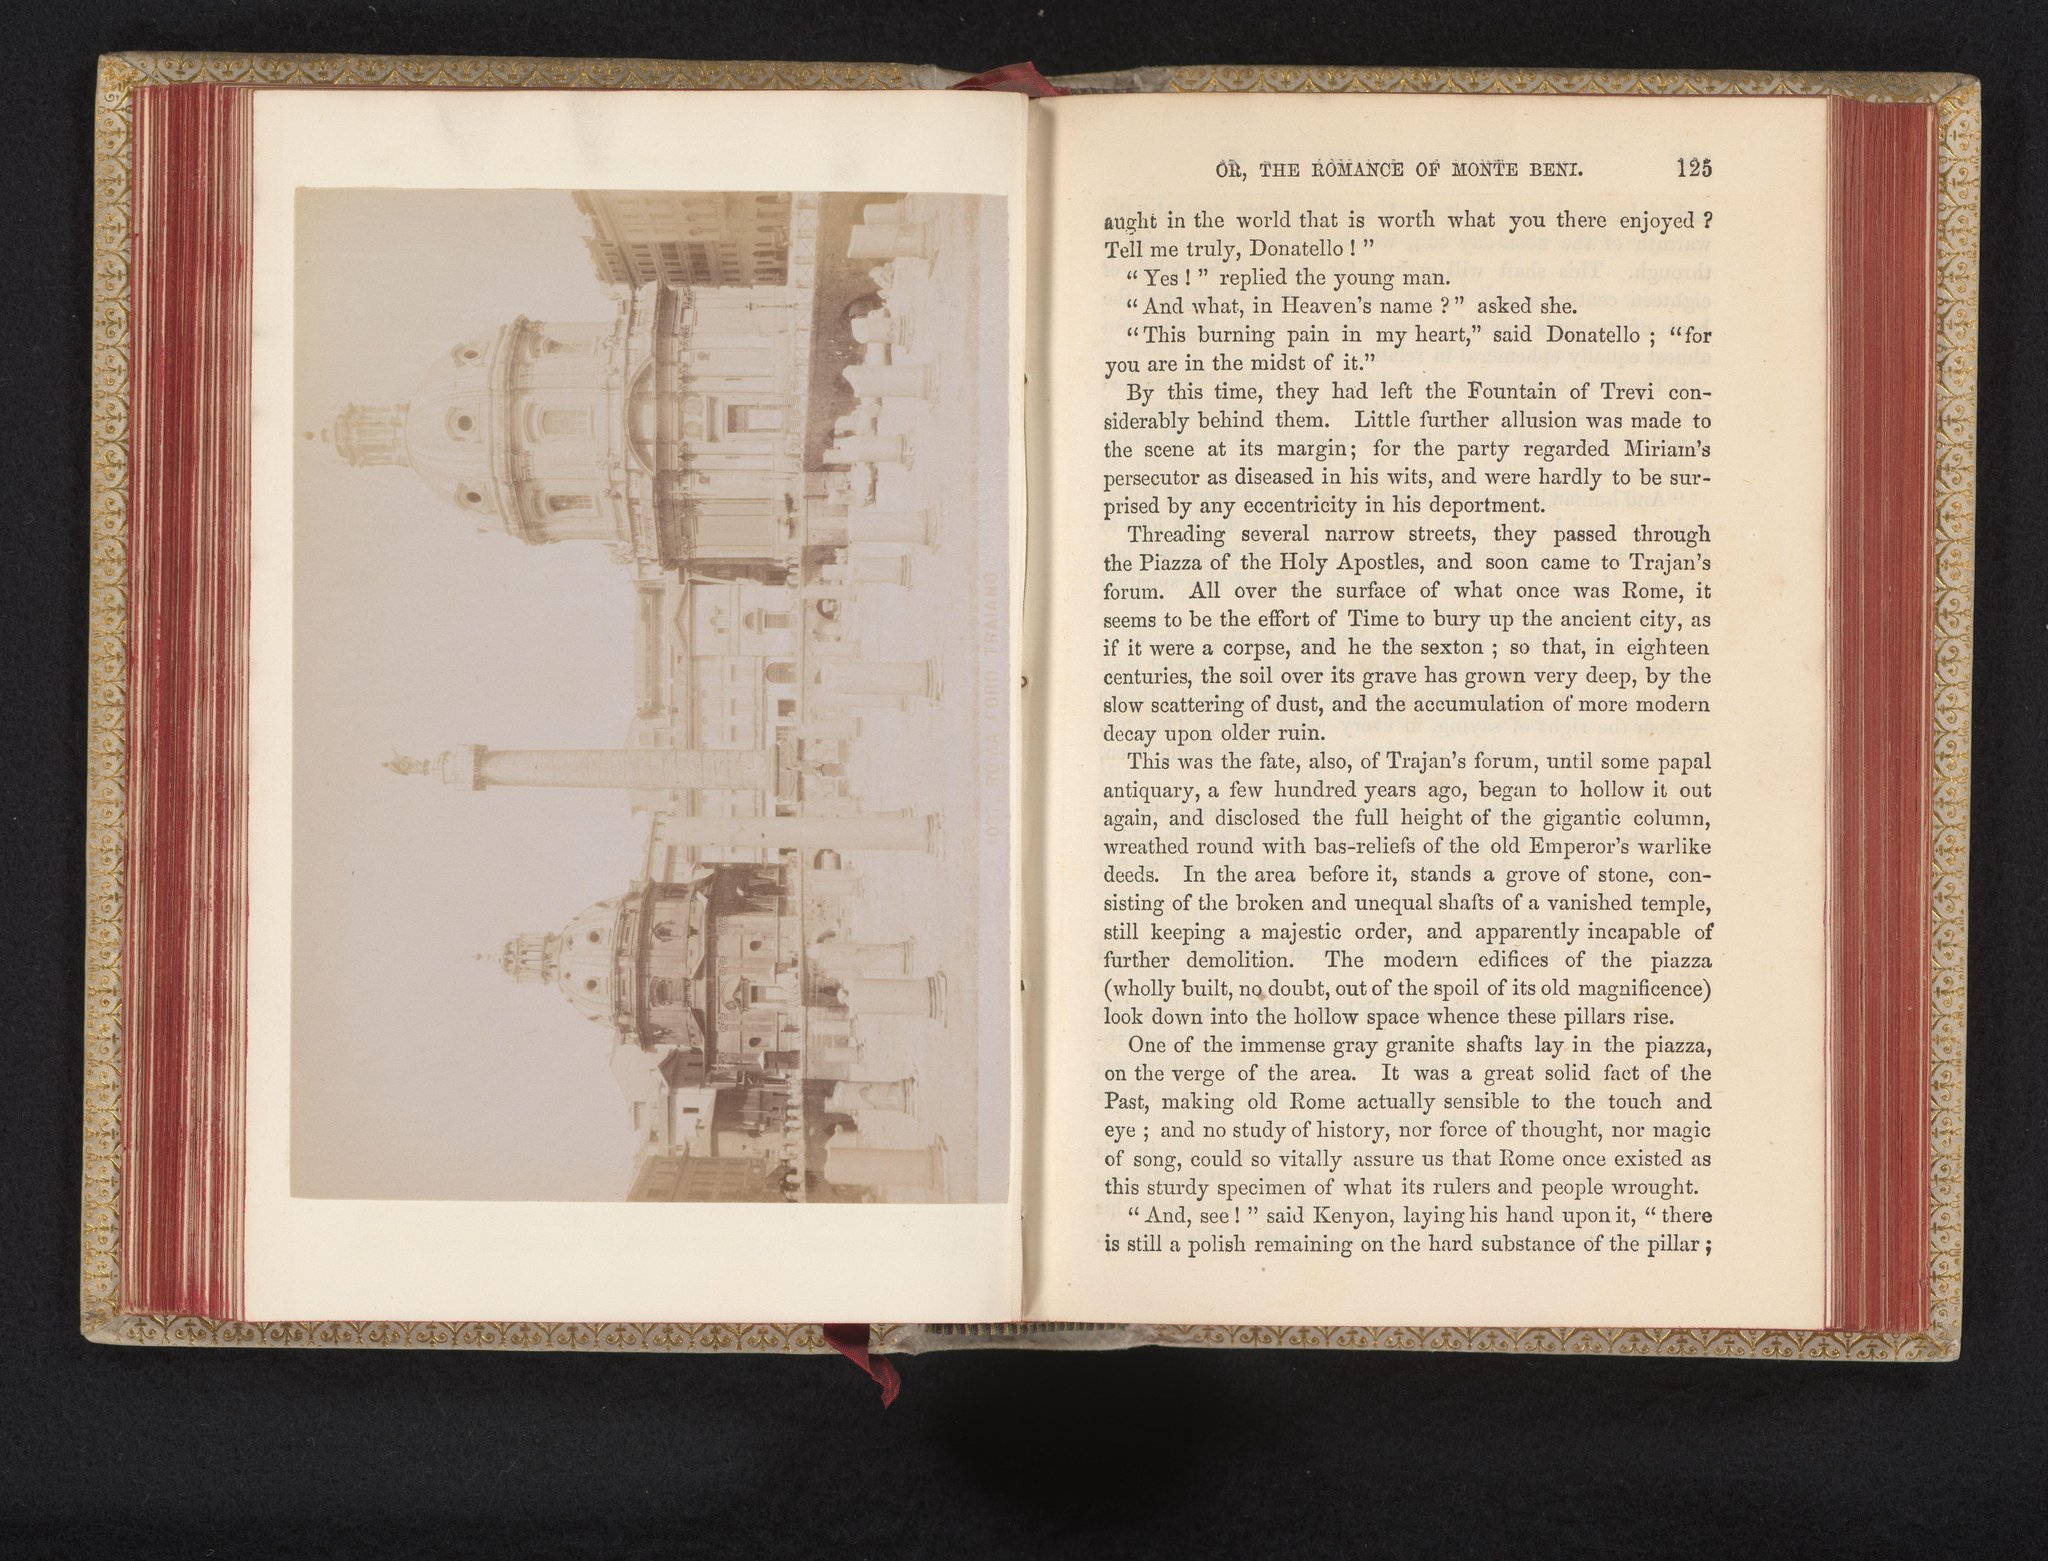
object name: page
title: Roma, Foro Traiano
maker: Anonymous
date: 1883-1888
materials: paper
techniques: albumen print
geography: rome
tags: landscape with ruins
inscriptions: number: ‘1037.’